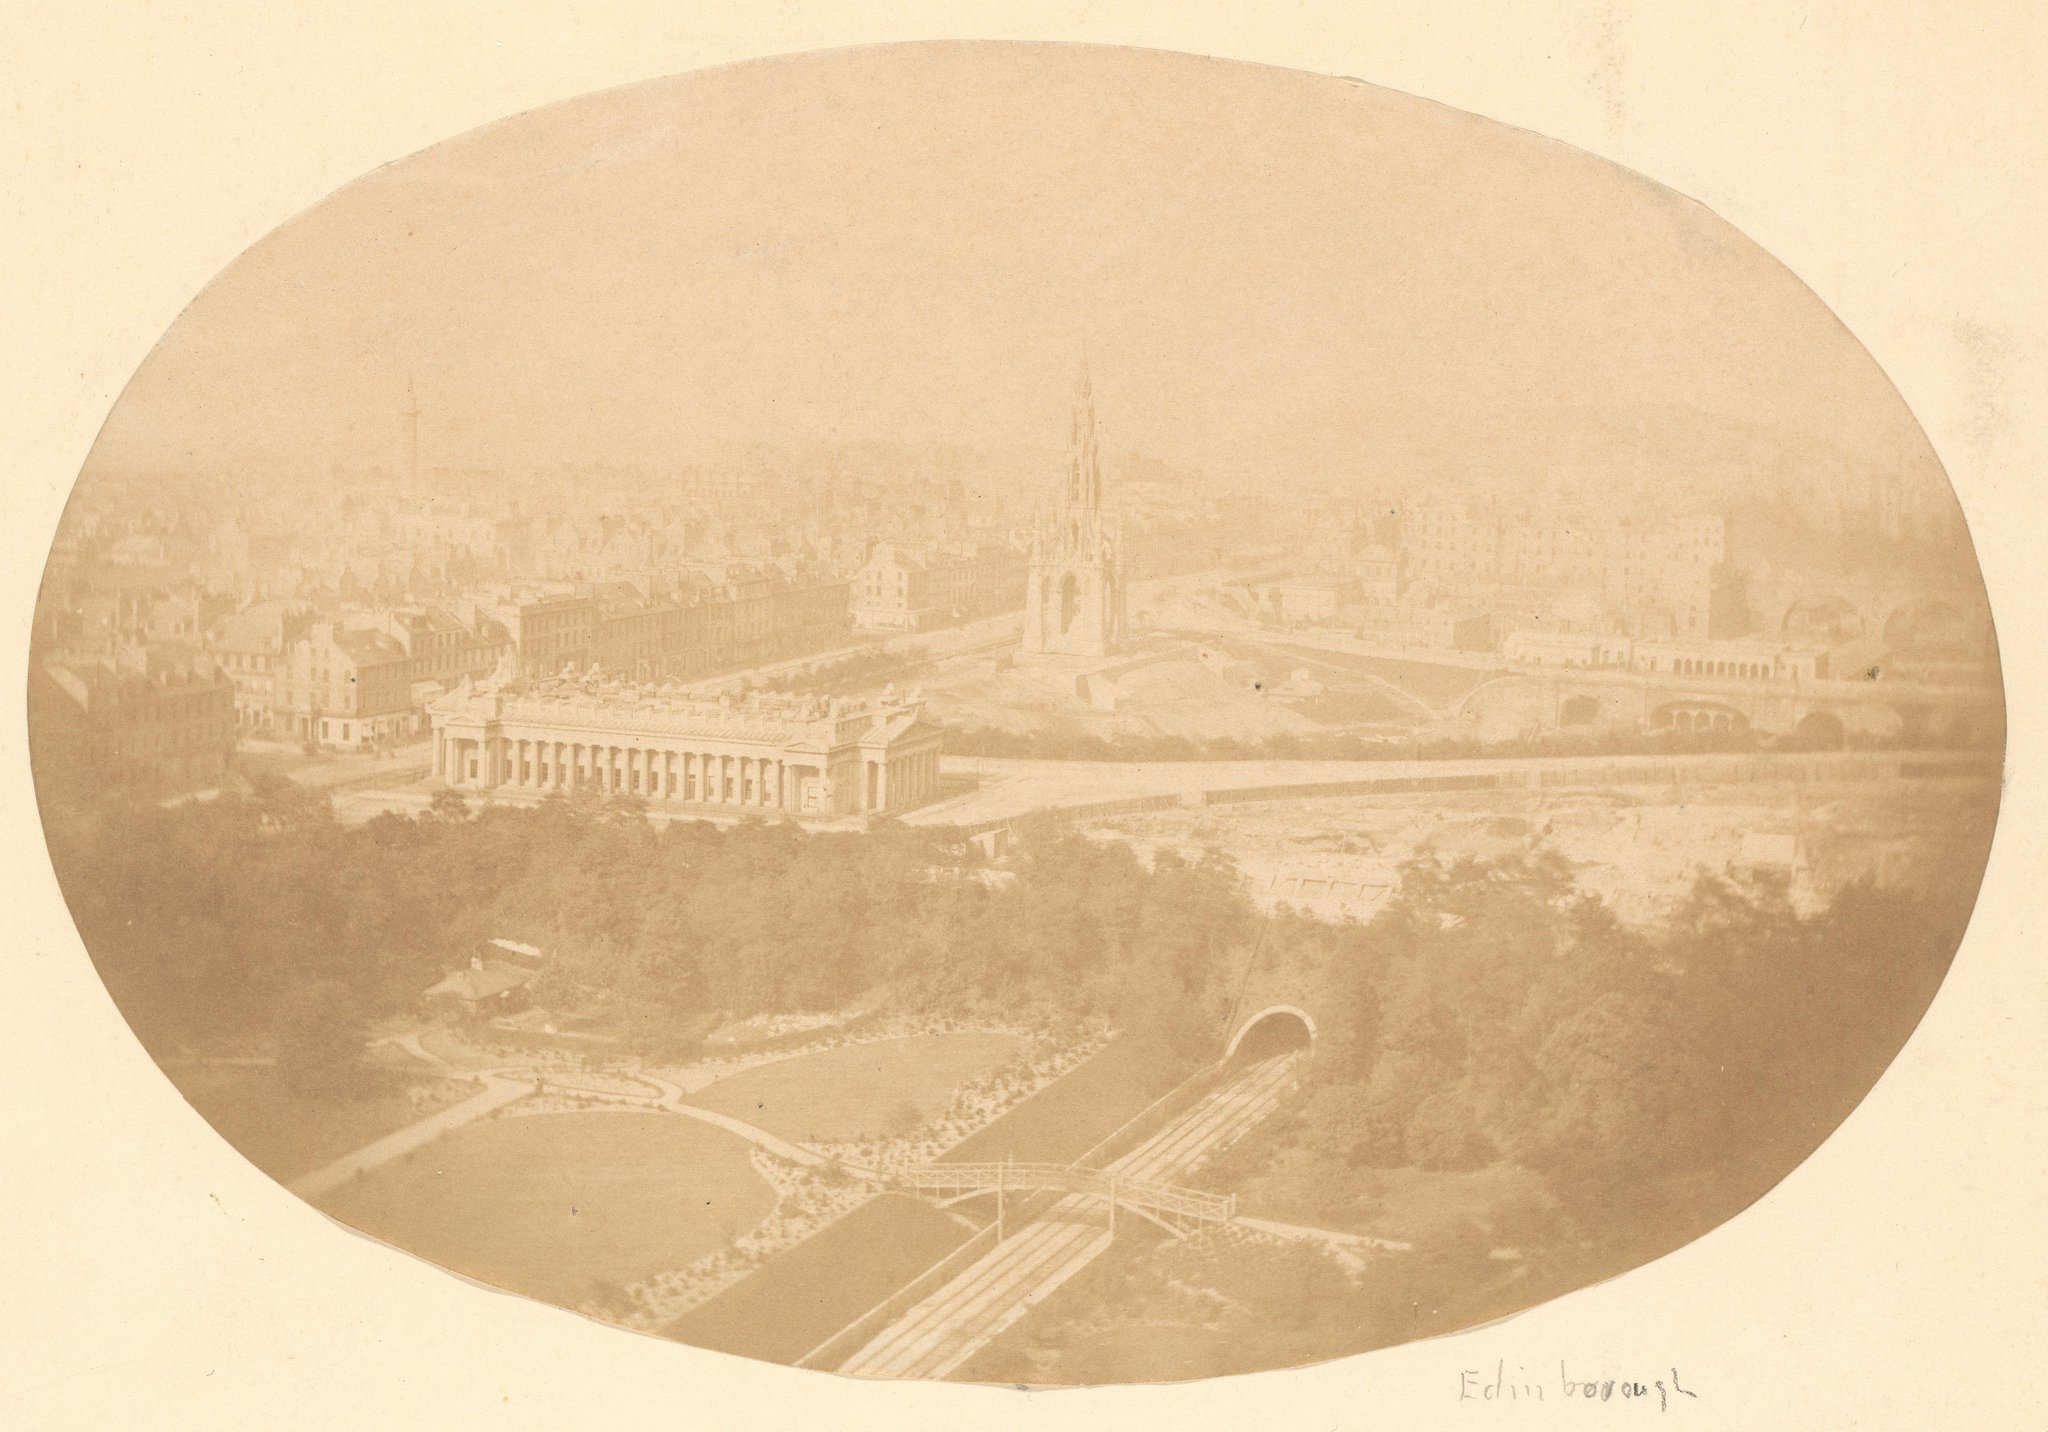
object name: photograph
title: Gezicht op Edinburgh, Schotland, in de verte het monument voor Sir Walter Scott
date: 1854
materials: cardboard, photographic support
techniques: salted paper print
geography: edinburgh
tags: city-view in general; 'veduta', monument, statue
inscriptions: retailer's mark: ‘MACGILL/ 7/ HANOVER/ ST./ EDINr.’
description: Zie History of Photography, jrg.1, no.1, p.78.